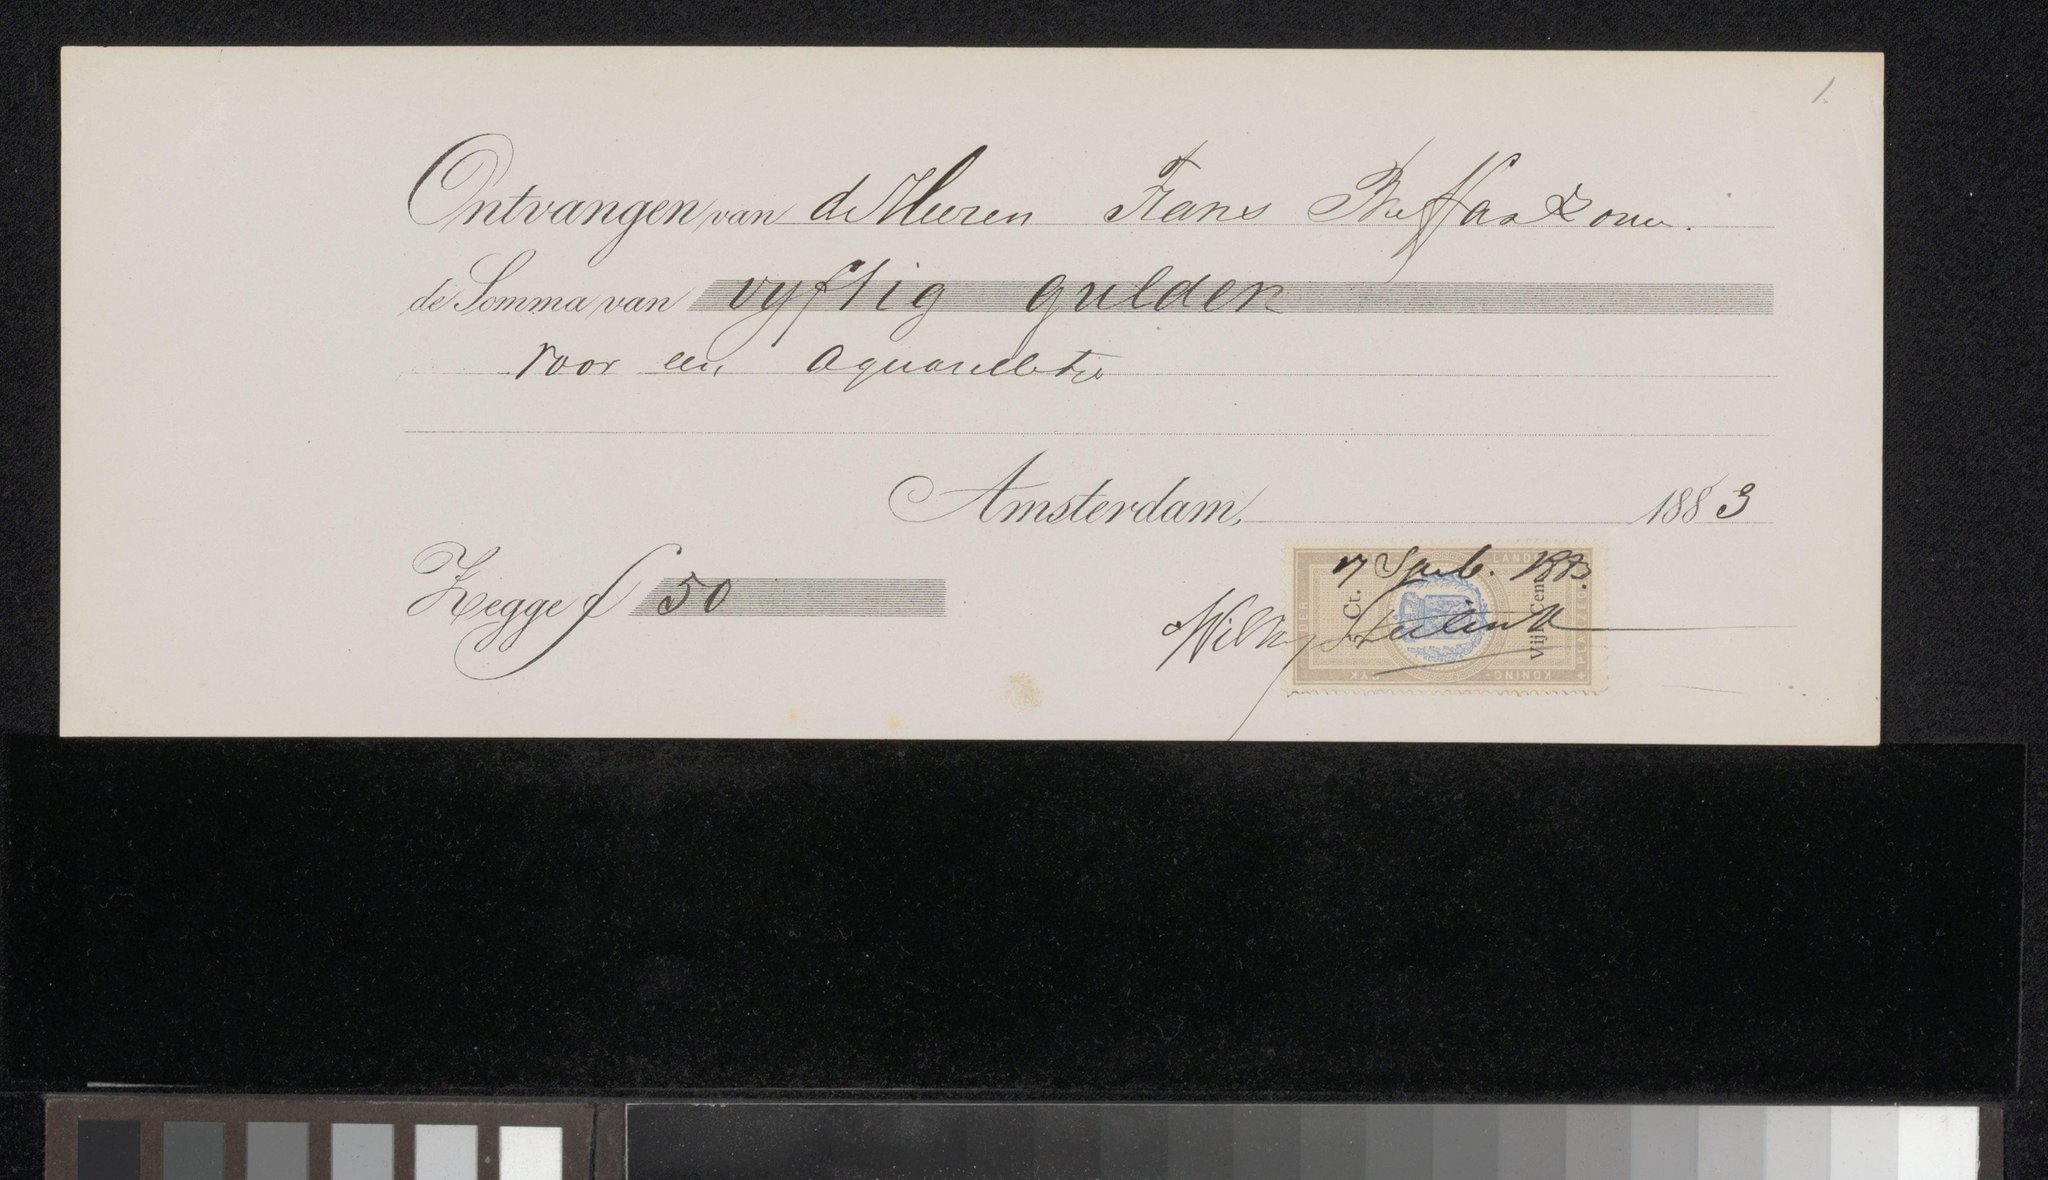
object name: ontvangstbewijs, kwitantie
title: Kwitantie voor Willem Steelinck (II)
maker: willem steelink (ii)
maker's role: draughtsman, print maker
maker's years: 1856-1928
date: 1883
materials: ink, paper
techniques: pen, printing, writing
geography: amsterdam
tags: amsterdam, voorburg, print maker, draughtsman, willem steelink (ii), drawing, money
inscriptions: collector's mark: Lugt 2233